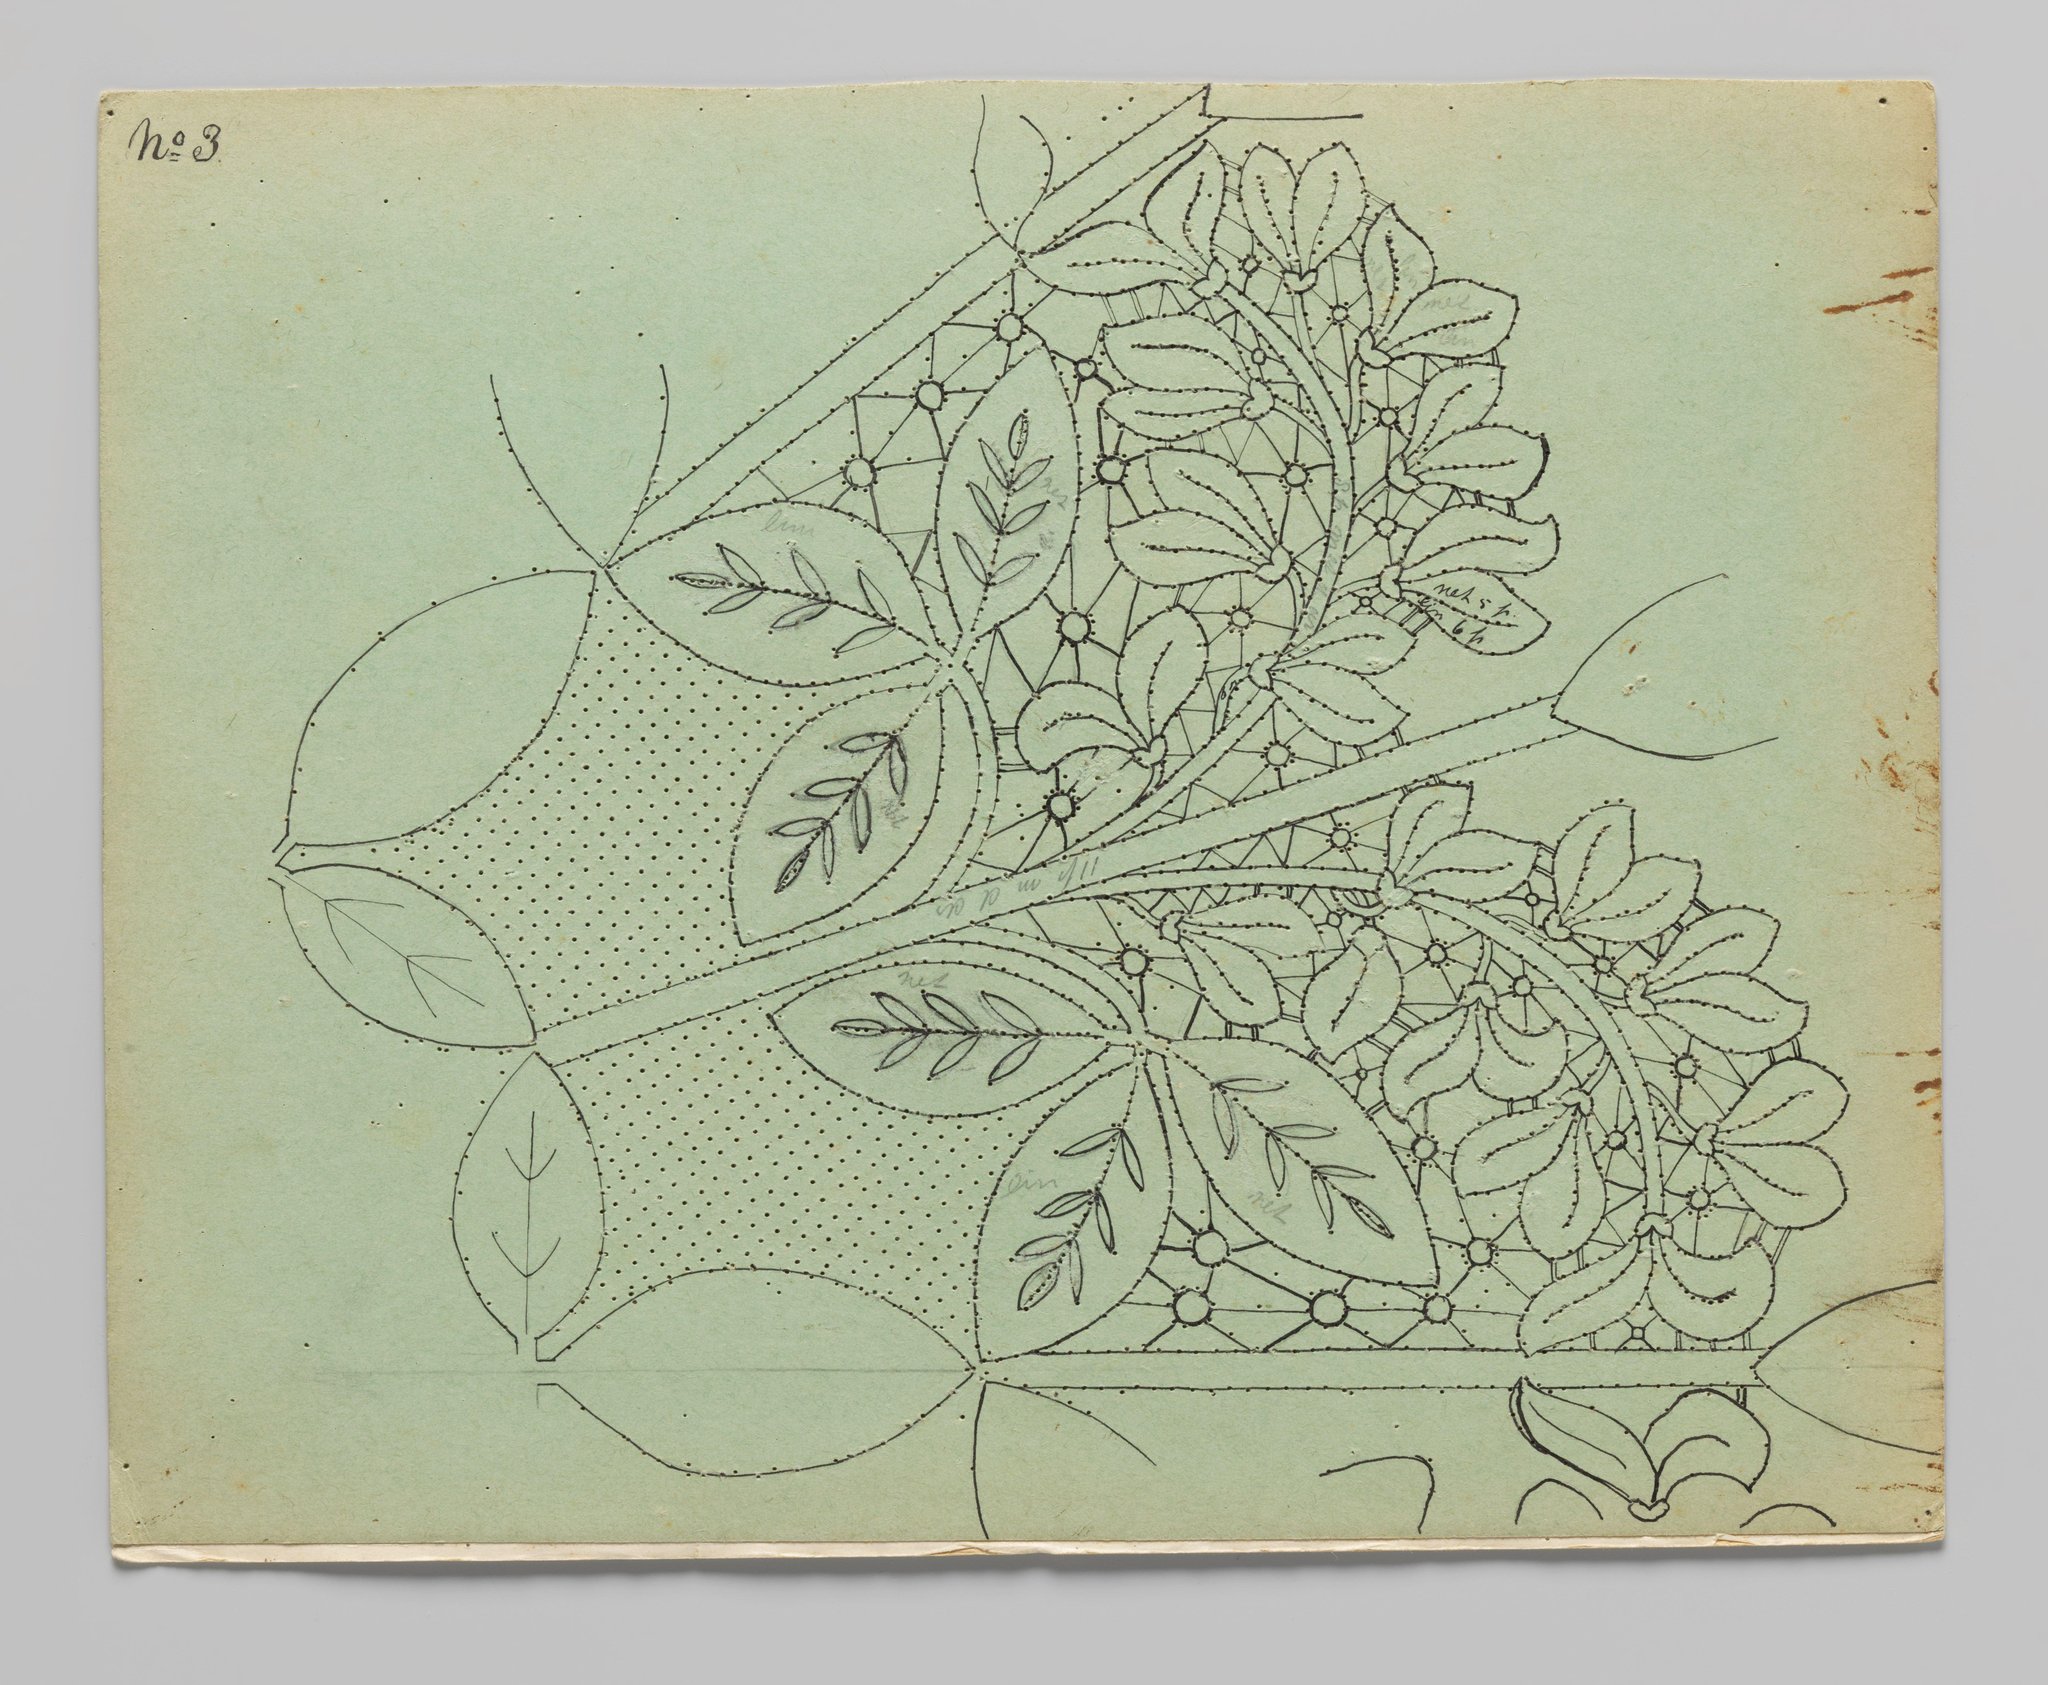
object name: lace pattern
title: Kantpatroon voor een kleed van kloskant met goudenregentakken en -bloemen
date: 1912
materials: paper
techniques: drawing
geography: apeldoorn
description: Kantbrief of kantpatroon met een deel van het patroon voor een kleed met invnr. BK-1979-84. De brief is genummerd (3) en heeft geschreven instructies op de achterkant.